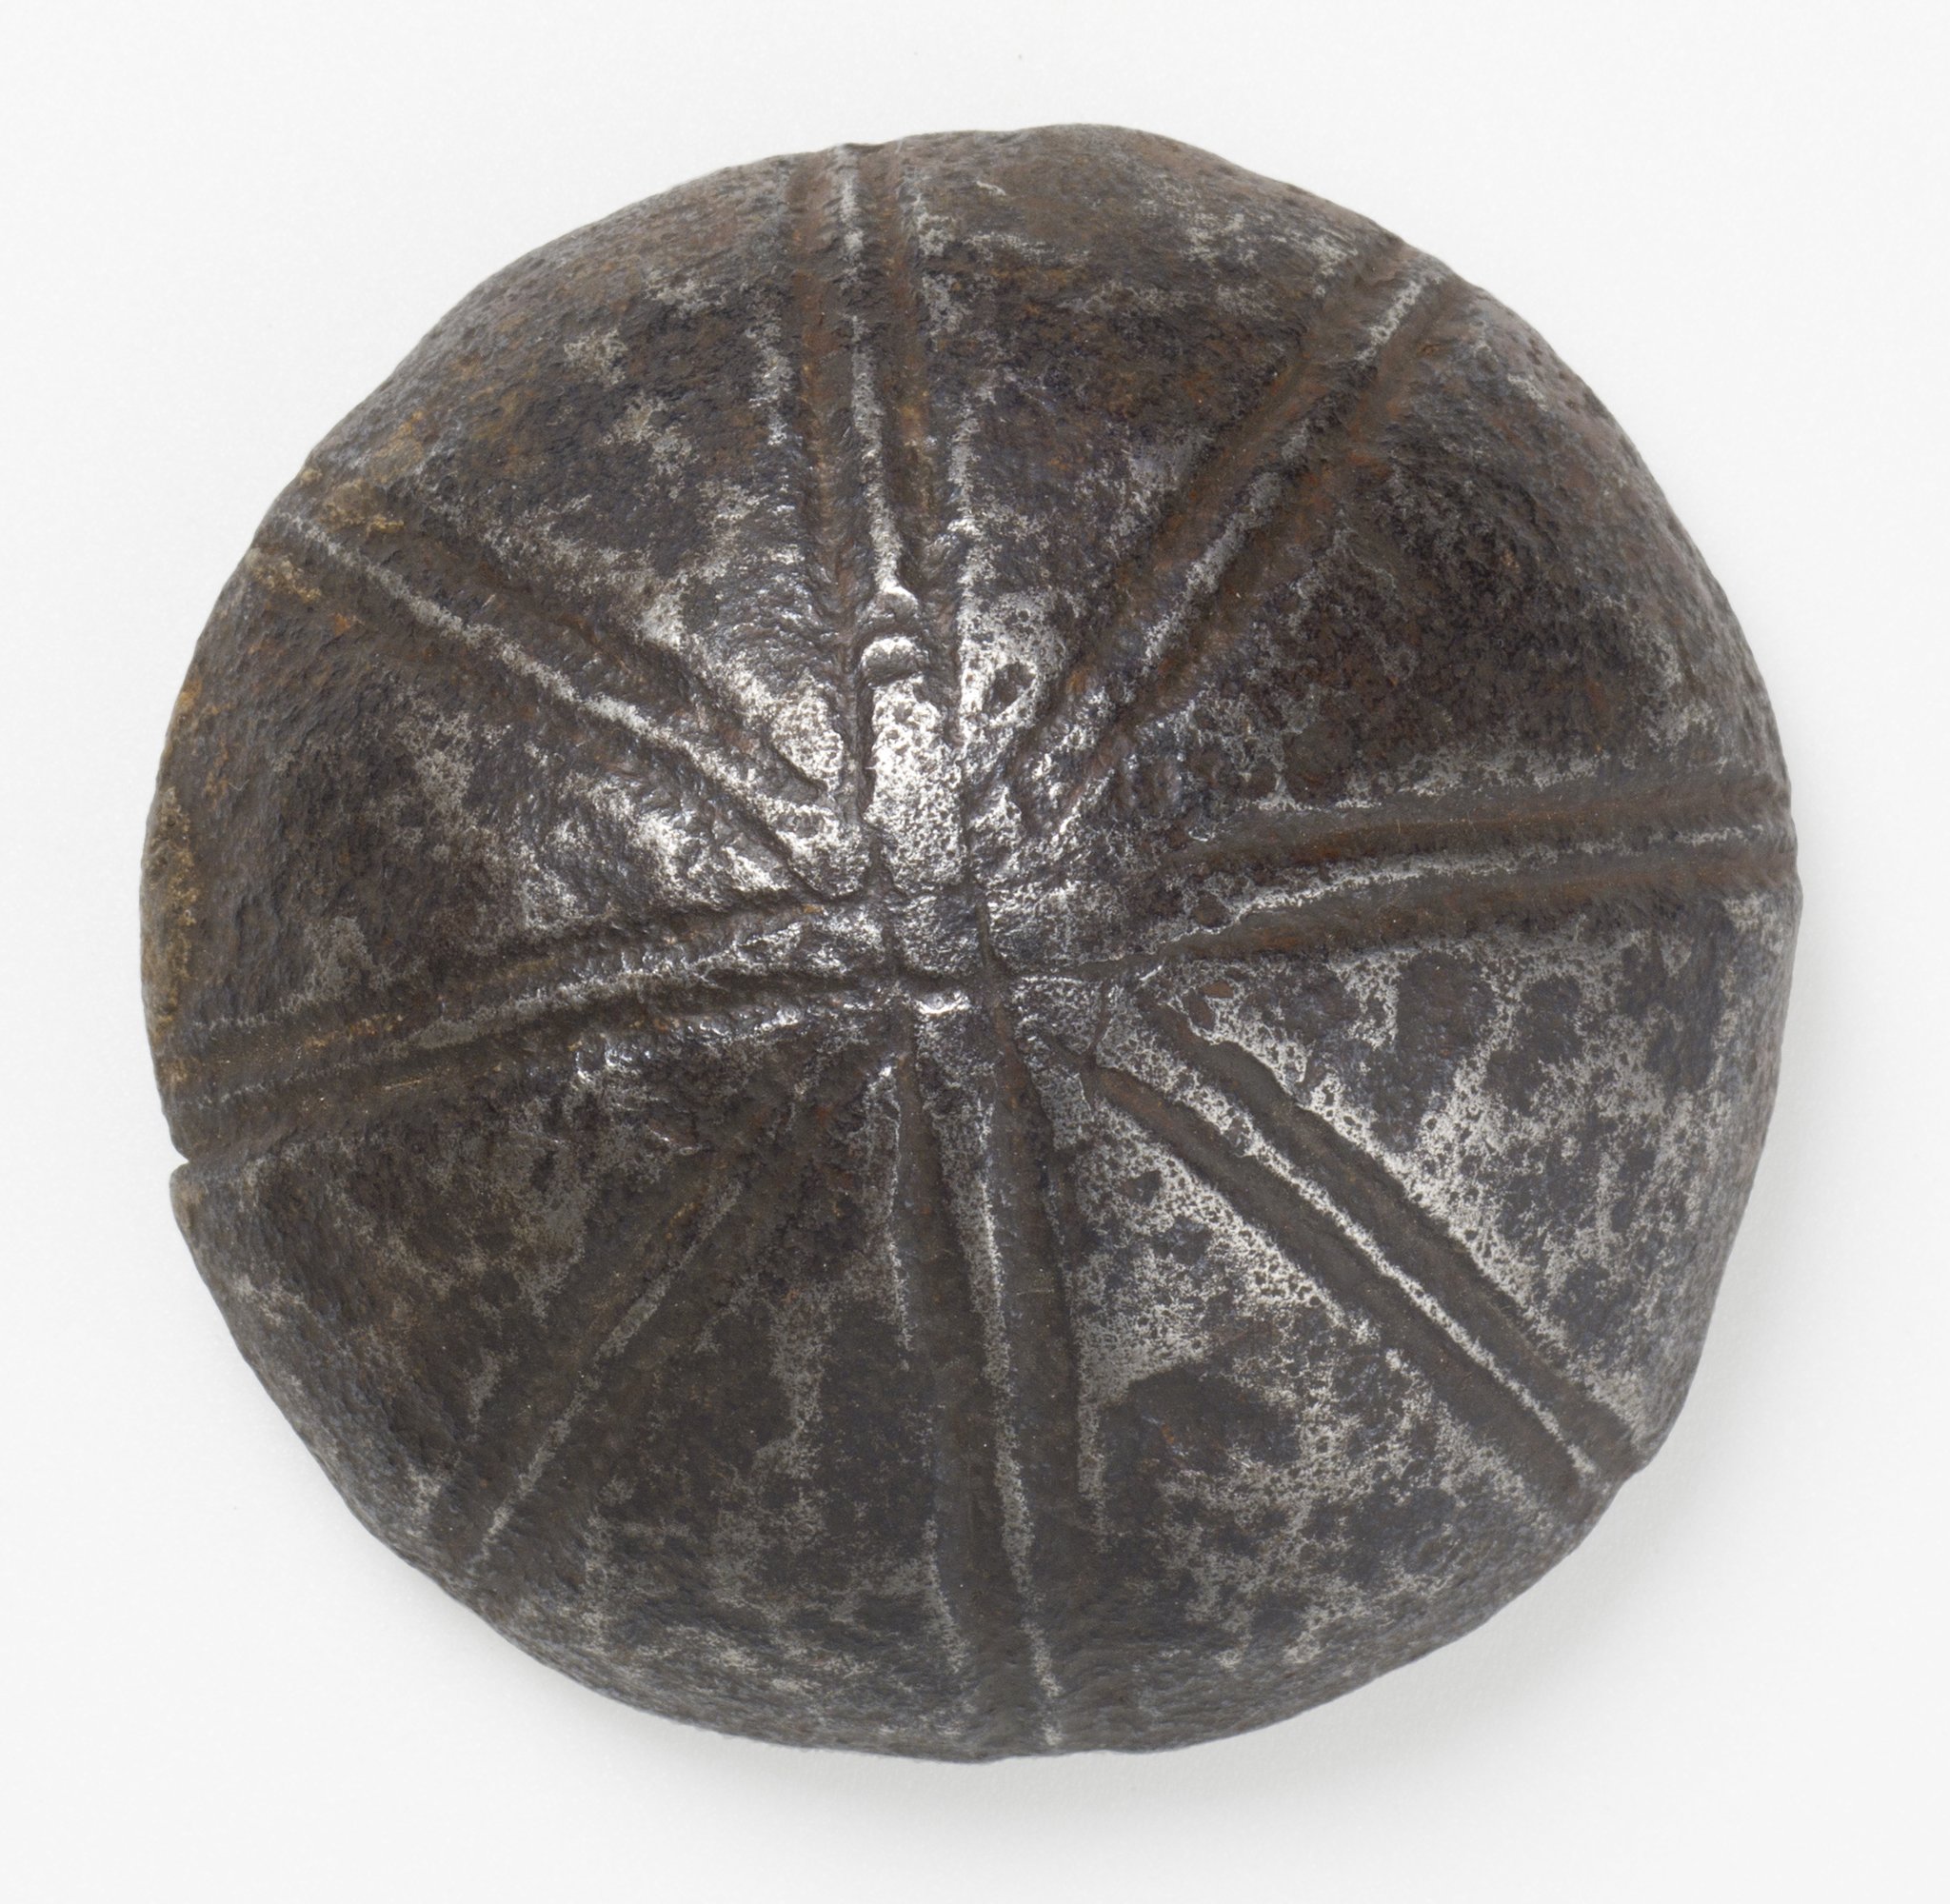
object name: nail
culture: european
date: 1401-1600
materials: iron